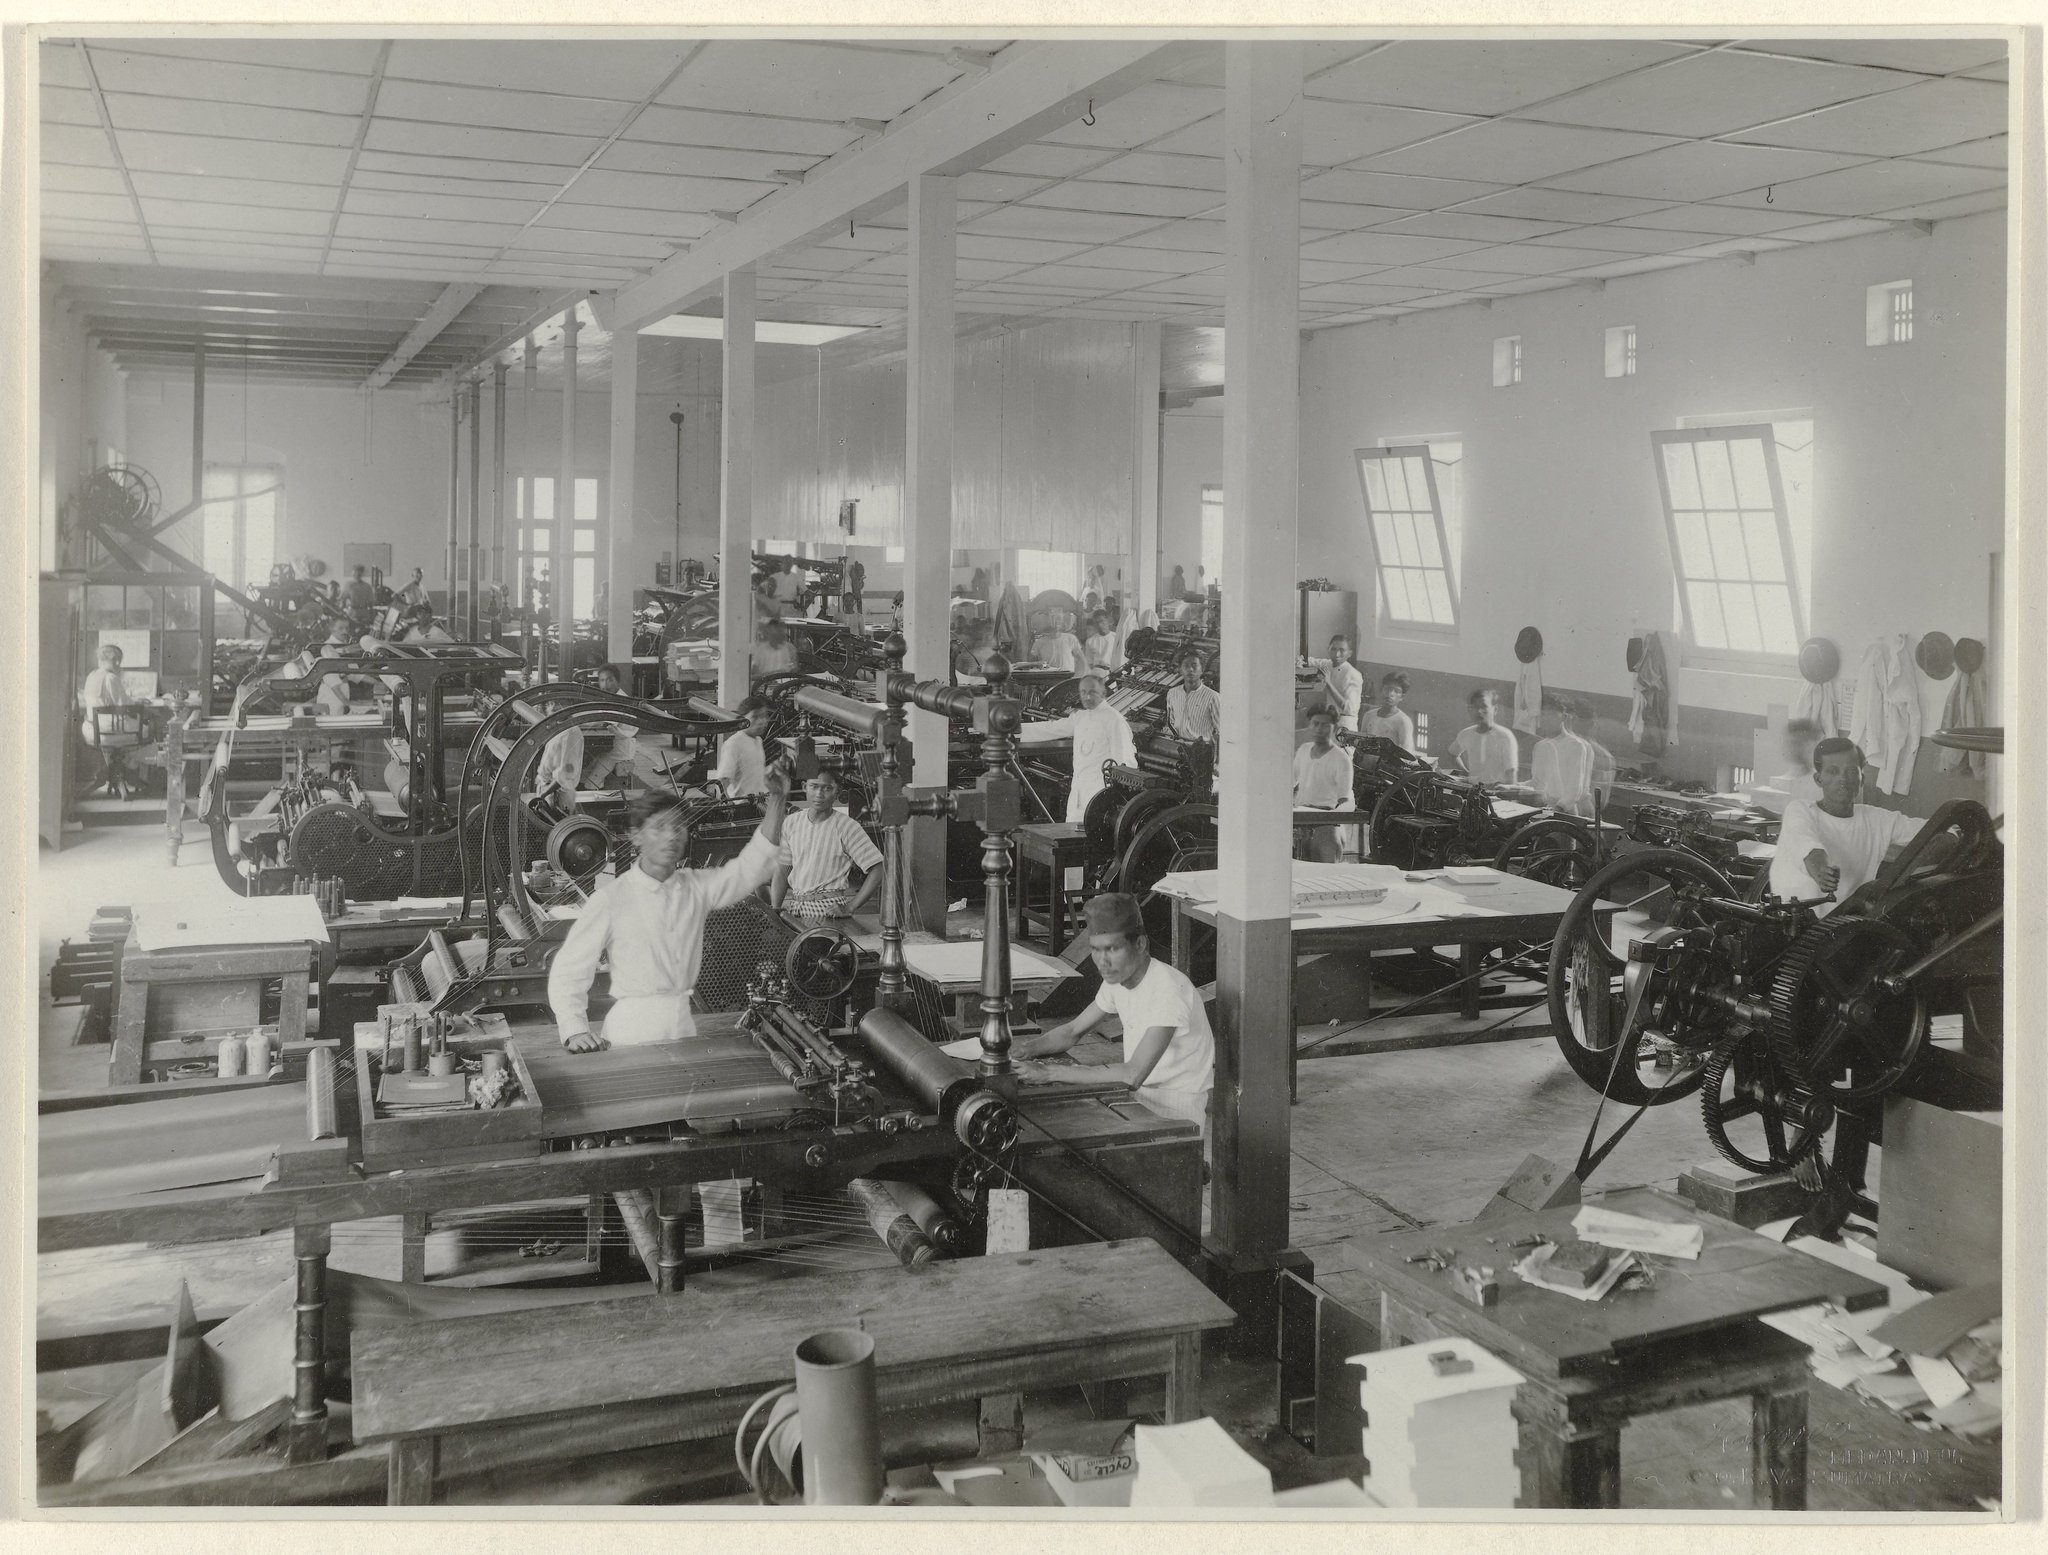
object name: photograph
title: Linieermachines op de drukkerij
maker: t. kaneo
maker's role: fotograaf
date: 1921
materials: photographic support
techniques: gelatin silver print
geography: medan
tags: dutch east indies, the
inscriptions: inscription: ‘Linieermachines’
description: De hal met de linieermachines op de drukkerij van de Deli Courant in Medan. Bij de machines staan de Javaanse werknemers. Onderdeel van een groep van 18 foto's uit 1921 binnen de groep van 49 losse zwart-wit foto's van verschillend formaat over de uitgeverij en drukkerij van de krant Deli Courant in Medan in de periode 1885-1947.